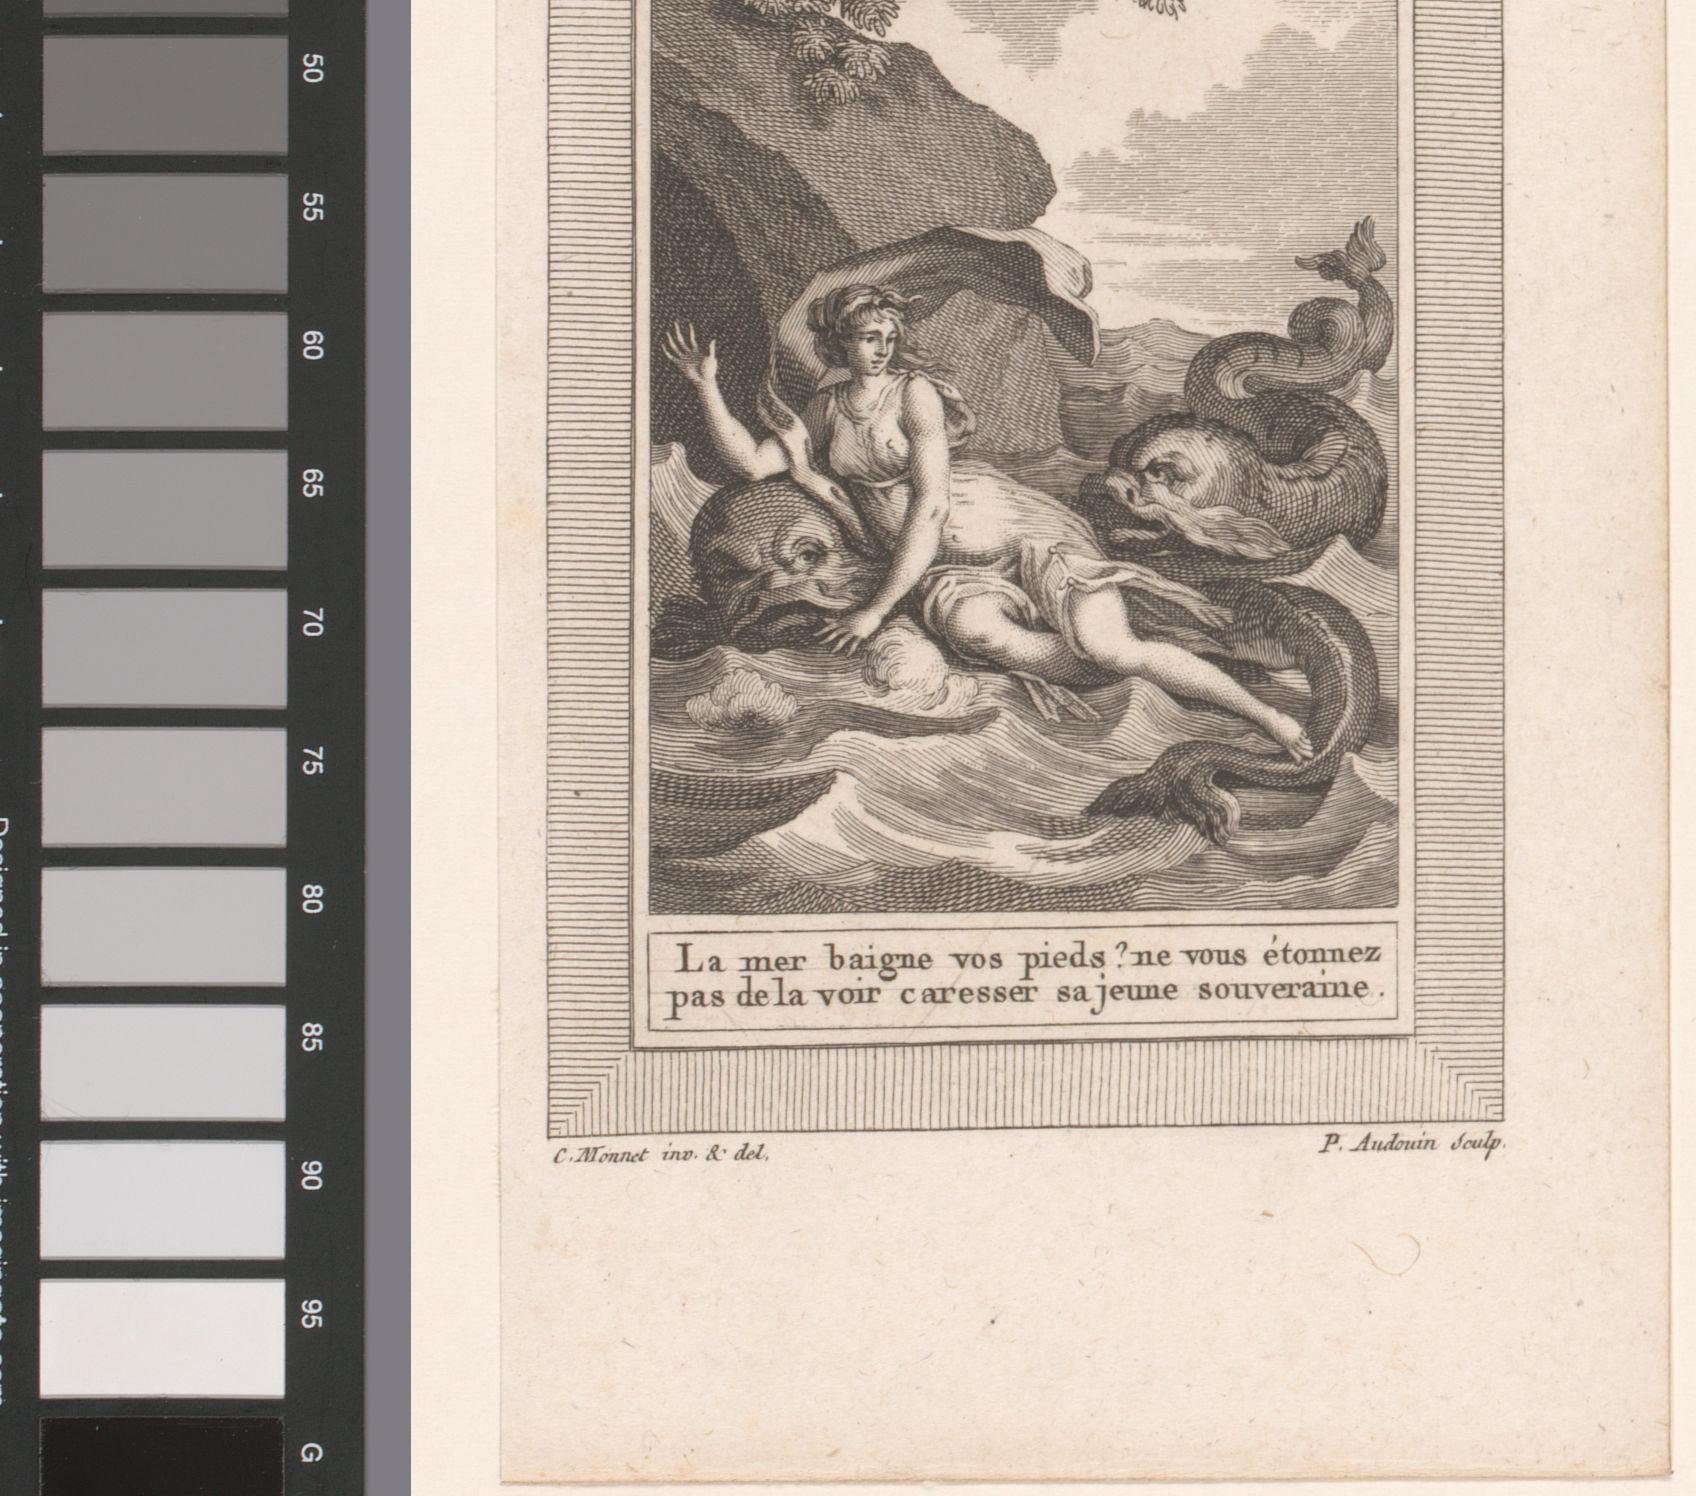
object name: book illustration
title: Amphitrite wordt ontvoerd door dolfijnen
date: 1801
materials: paper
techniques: engraving, etching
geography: paris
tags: amphitrite riding on a dolphin; possibly brought to neptune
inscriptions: collector's mark: Lugt 2228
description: Prent uit: C.A. Demoustier. Lettres a Émilie, sur la mythologie. Paris: A.A. Renouard, 1801.